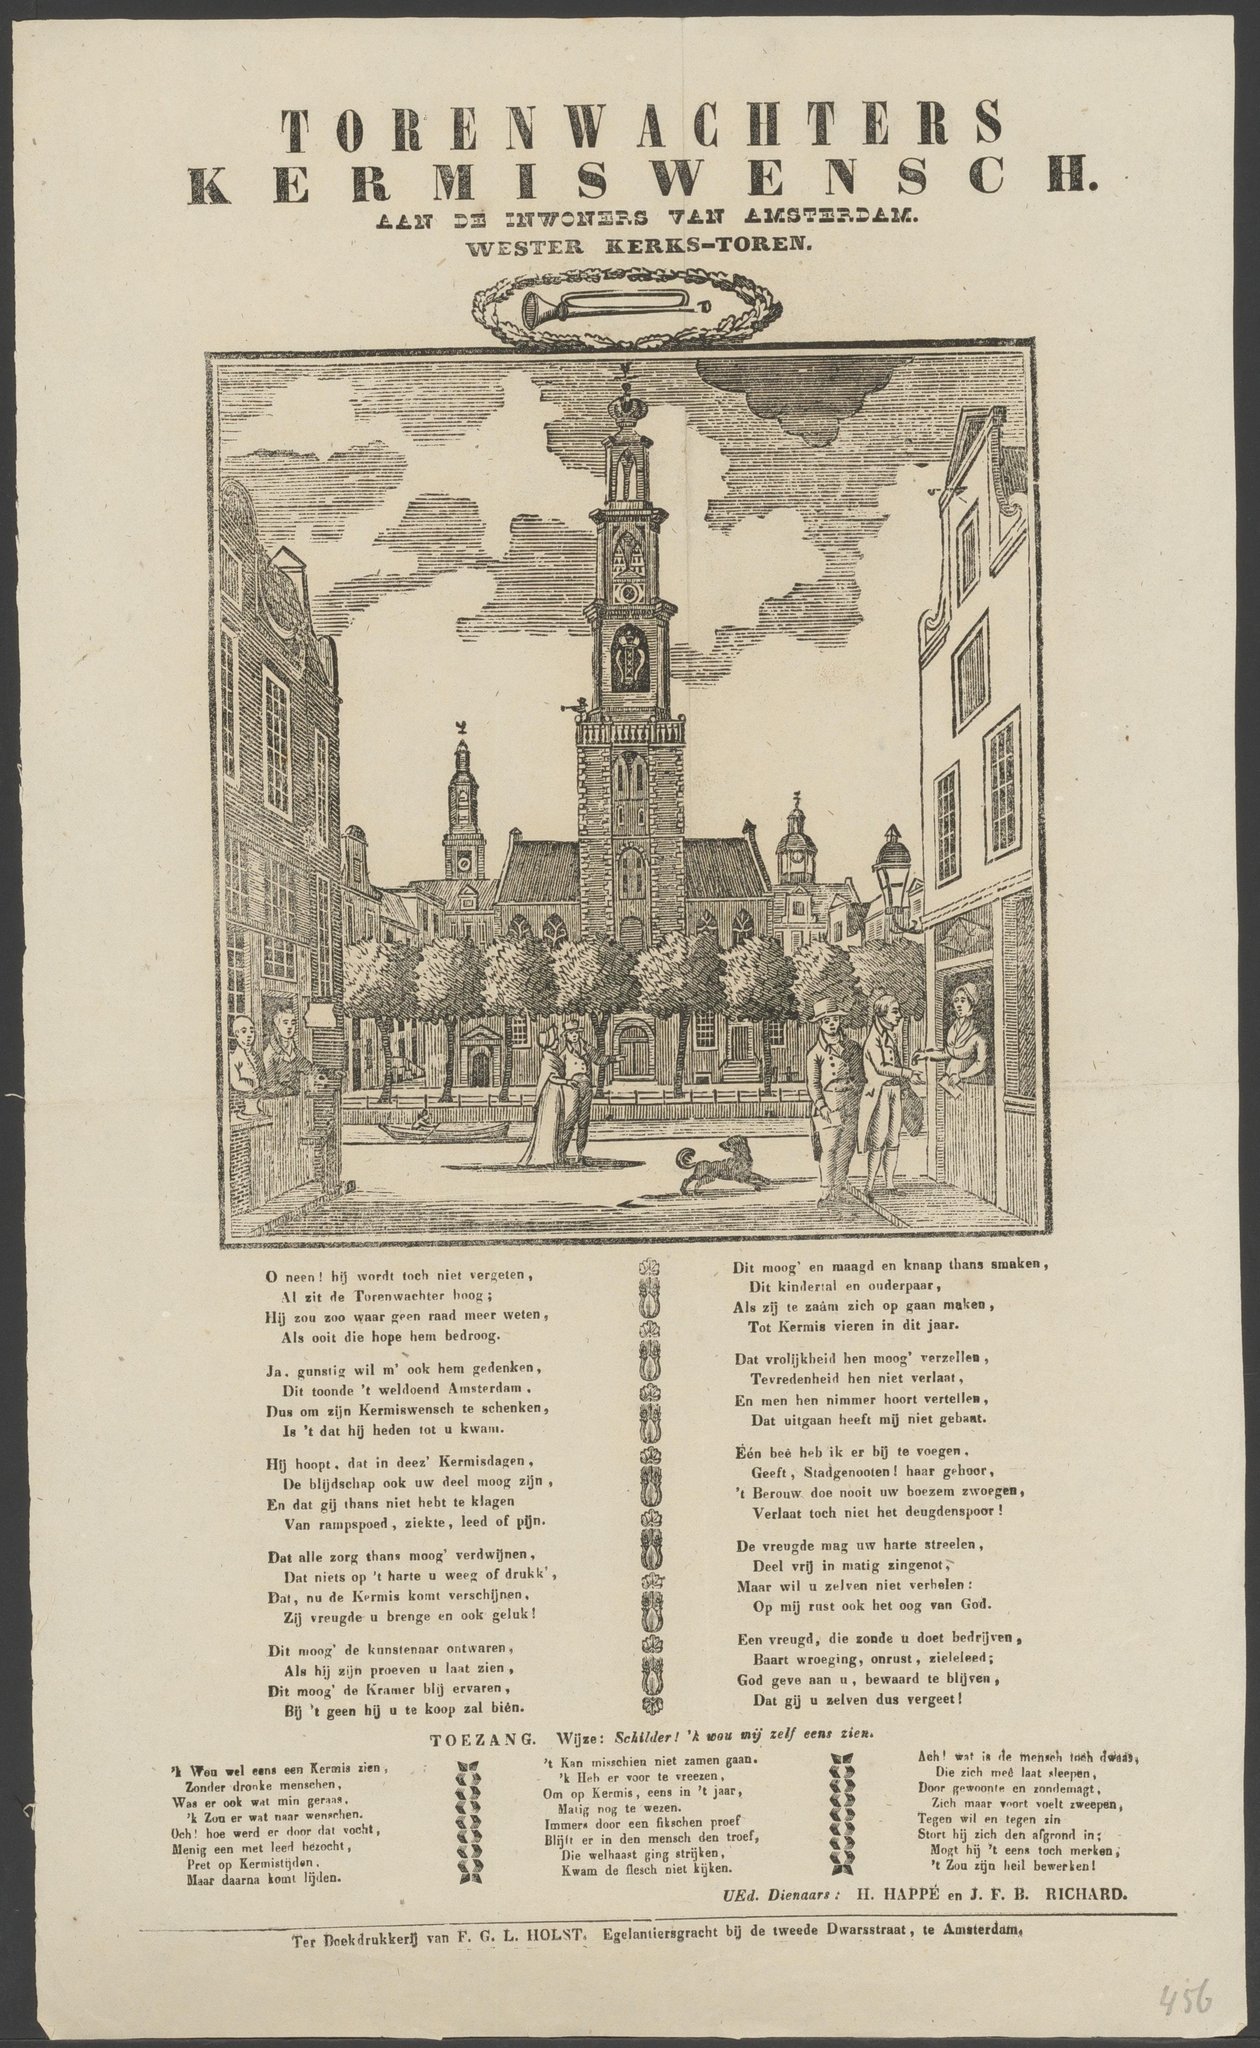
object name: print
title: Torenwachters Kermiswensch aan de inwoners van Amsterdam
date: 1841-1864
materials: paper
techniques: letterpress printing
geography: amsterdam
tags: night patrol, tower (of house or building)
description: Kermiswens van de torenwachters van de stad Amsterdam. Bovenaan een trompet met daaronder een een toren in de stad Amterdam met een torenwachter. Onderaan een vers in twee kolommen en een toezang in drie kolommen. Aangeboden door de torenwachters van de toren van de Westerkerk: H. Happé en J.F.B. Richard. Onderwerpsrubrieken binnen de Atlas Zeden en Gewoonten: Zeden en gewoonten in engeren zin, Volksleven, Volksbladen, Nieuwjaars- en Kerstwenschen, Amsterdam.